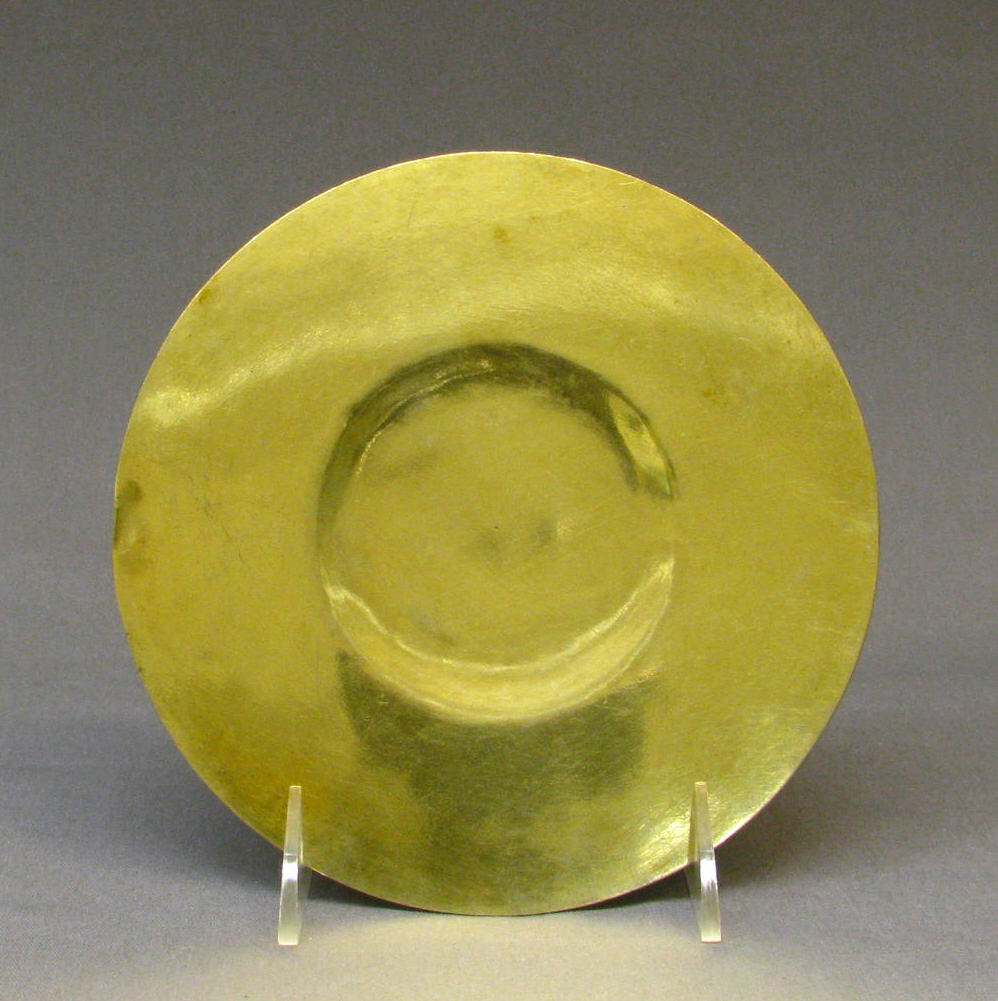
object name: paten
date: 1701-1800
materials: silver gilt